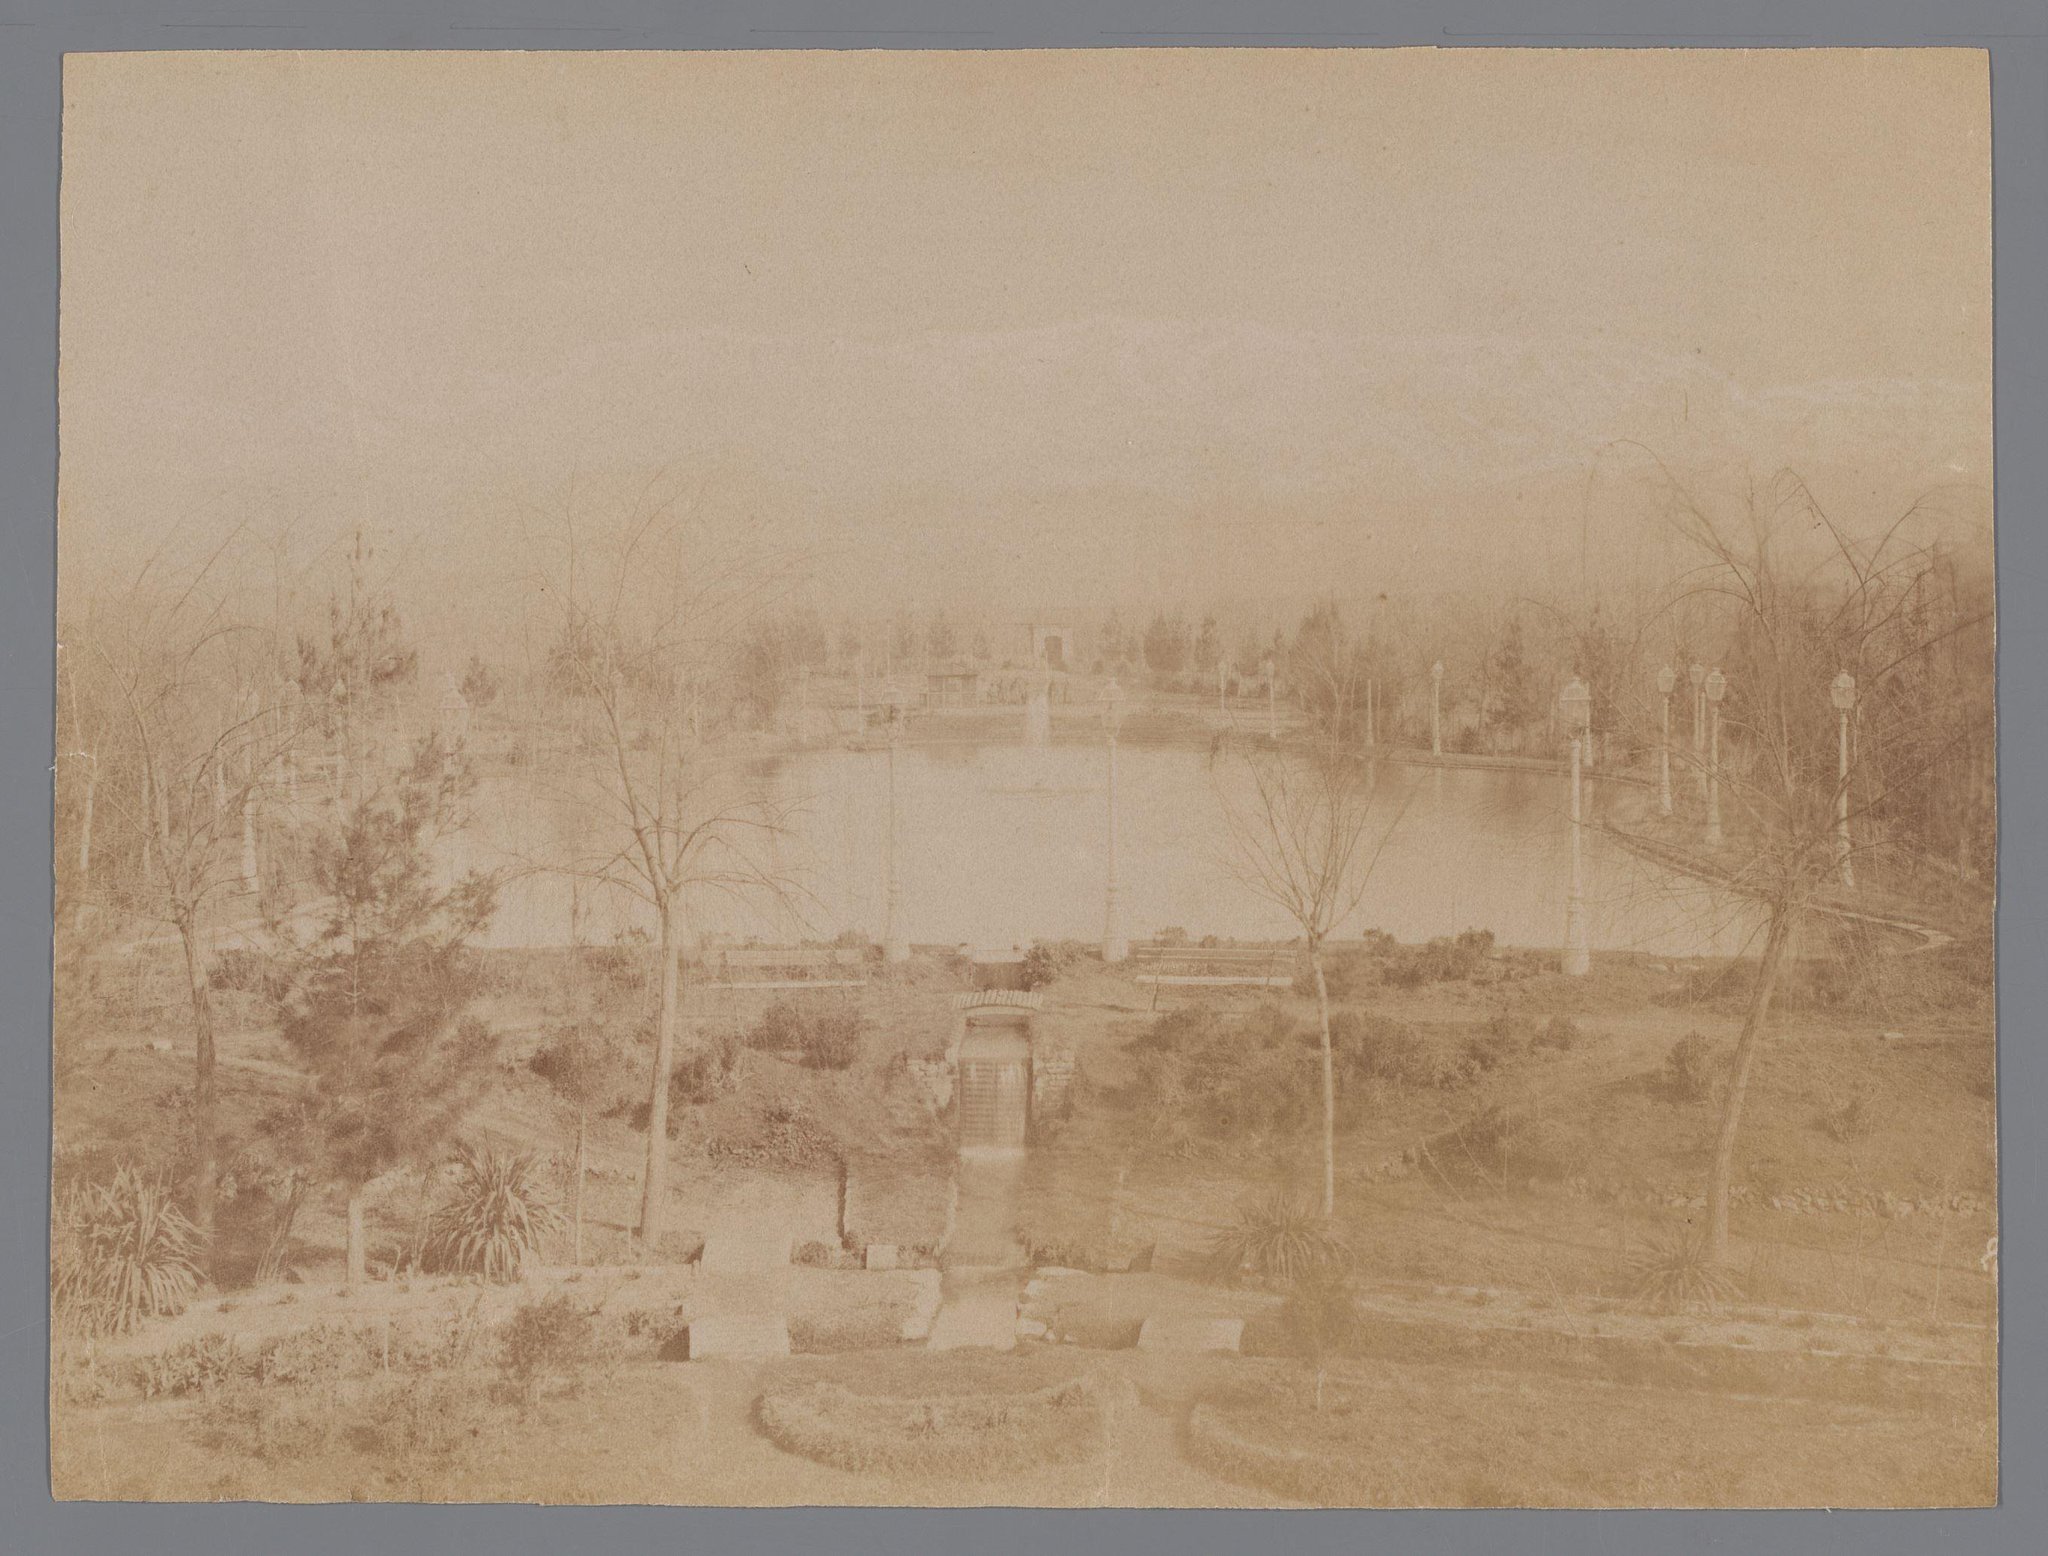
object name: photograph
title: Park in Teheran, Iran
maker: antoine sevruguin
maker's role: fotograaf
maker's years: 1840-1933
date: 1885-1910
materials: paper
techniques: albumen print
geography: iran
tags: teheran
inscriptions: number: ‘16.’, inscription: ‘W263//Teheran Parc de Sadrazan [?]’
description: Park in Teheran, Iran ["Parc de Sadrazan"[?]].